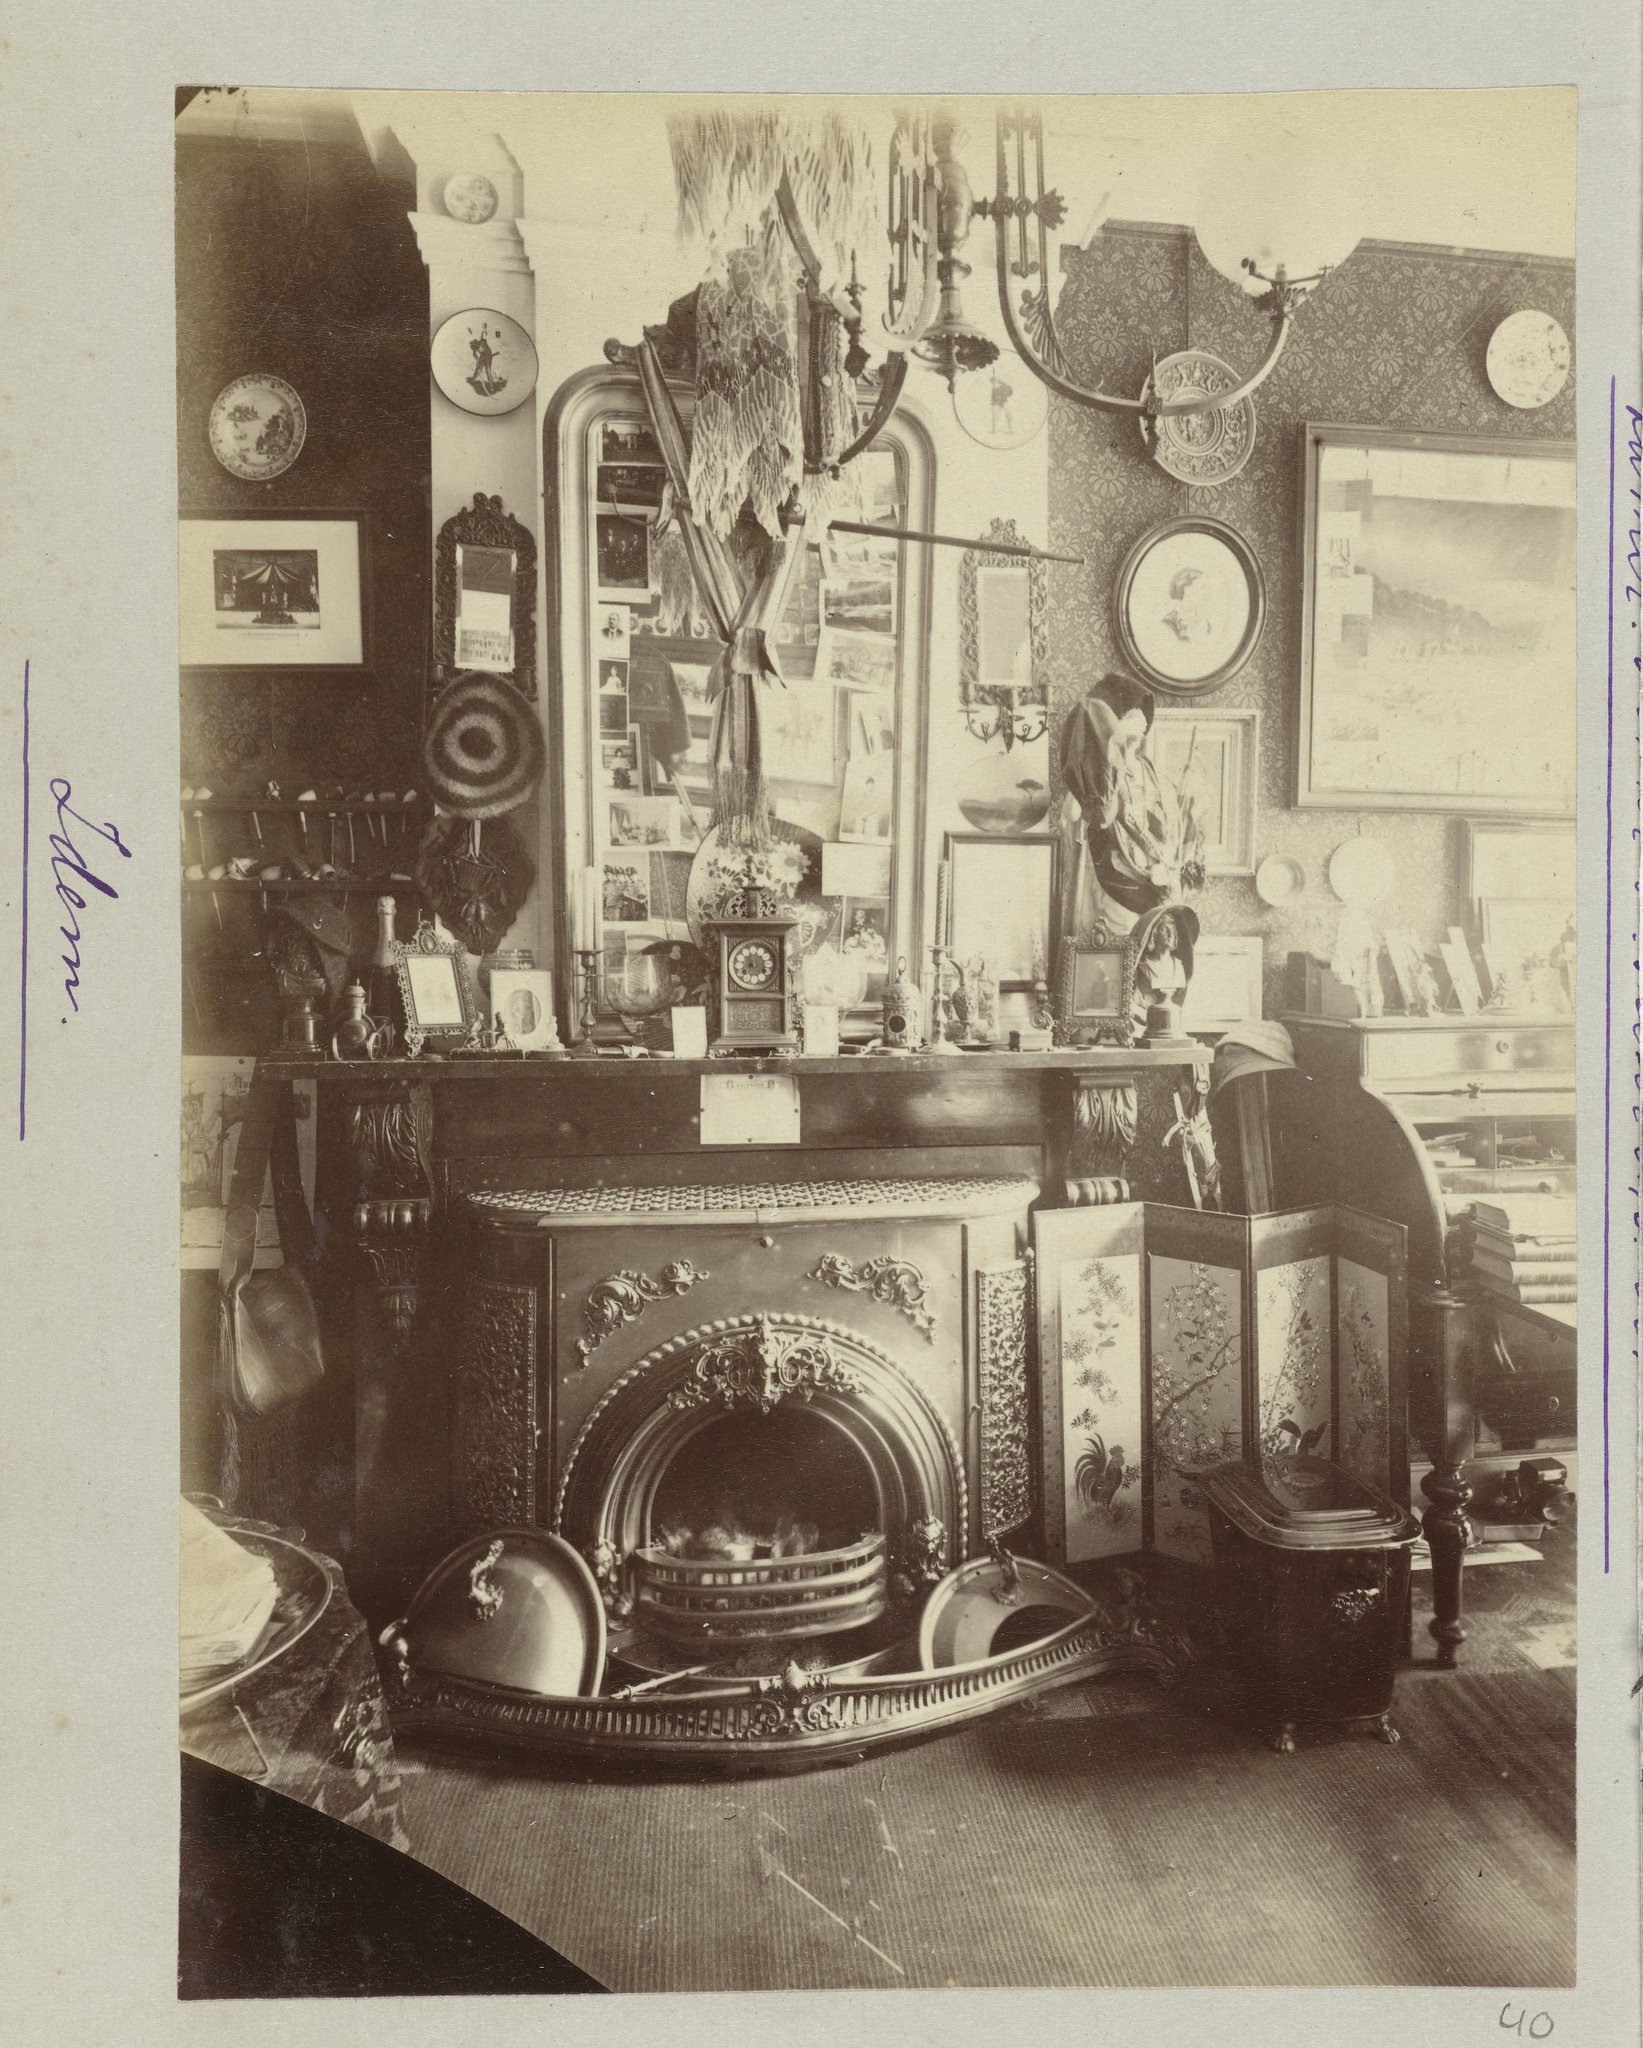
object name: photograph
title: Student Rooms of Pauw van Wieldrecht’s Friends in Utrecht and The Hague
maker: henry pauw van wieldrecht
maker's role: fotograaf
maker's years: 1863-1912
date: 1889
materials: paper, photographic support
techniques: albumen print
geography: netherlands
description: Pauw van Wieldrecht sometimes took part in photography exhibitions. The Rijksmuseum owns around four hundred of his photographs and various albums. The amount of work preserved is more than that of any other amateur of the late 19th century.